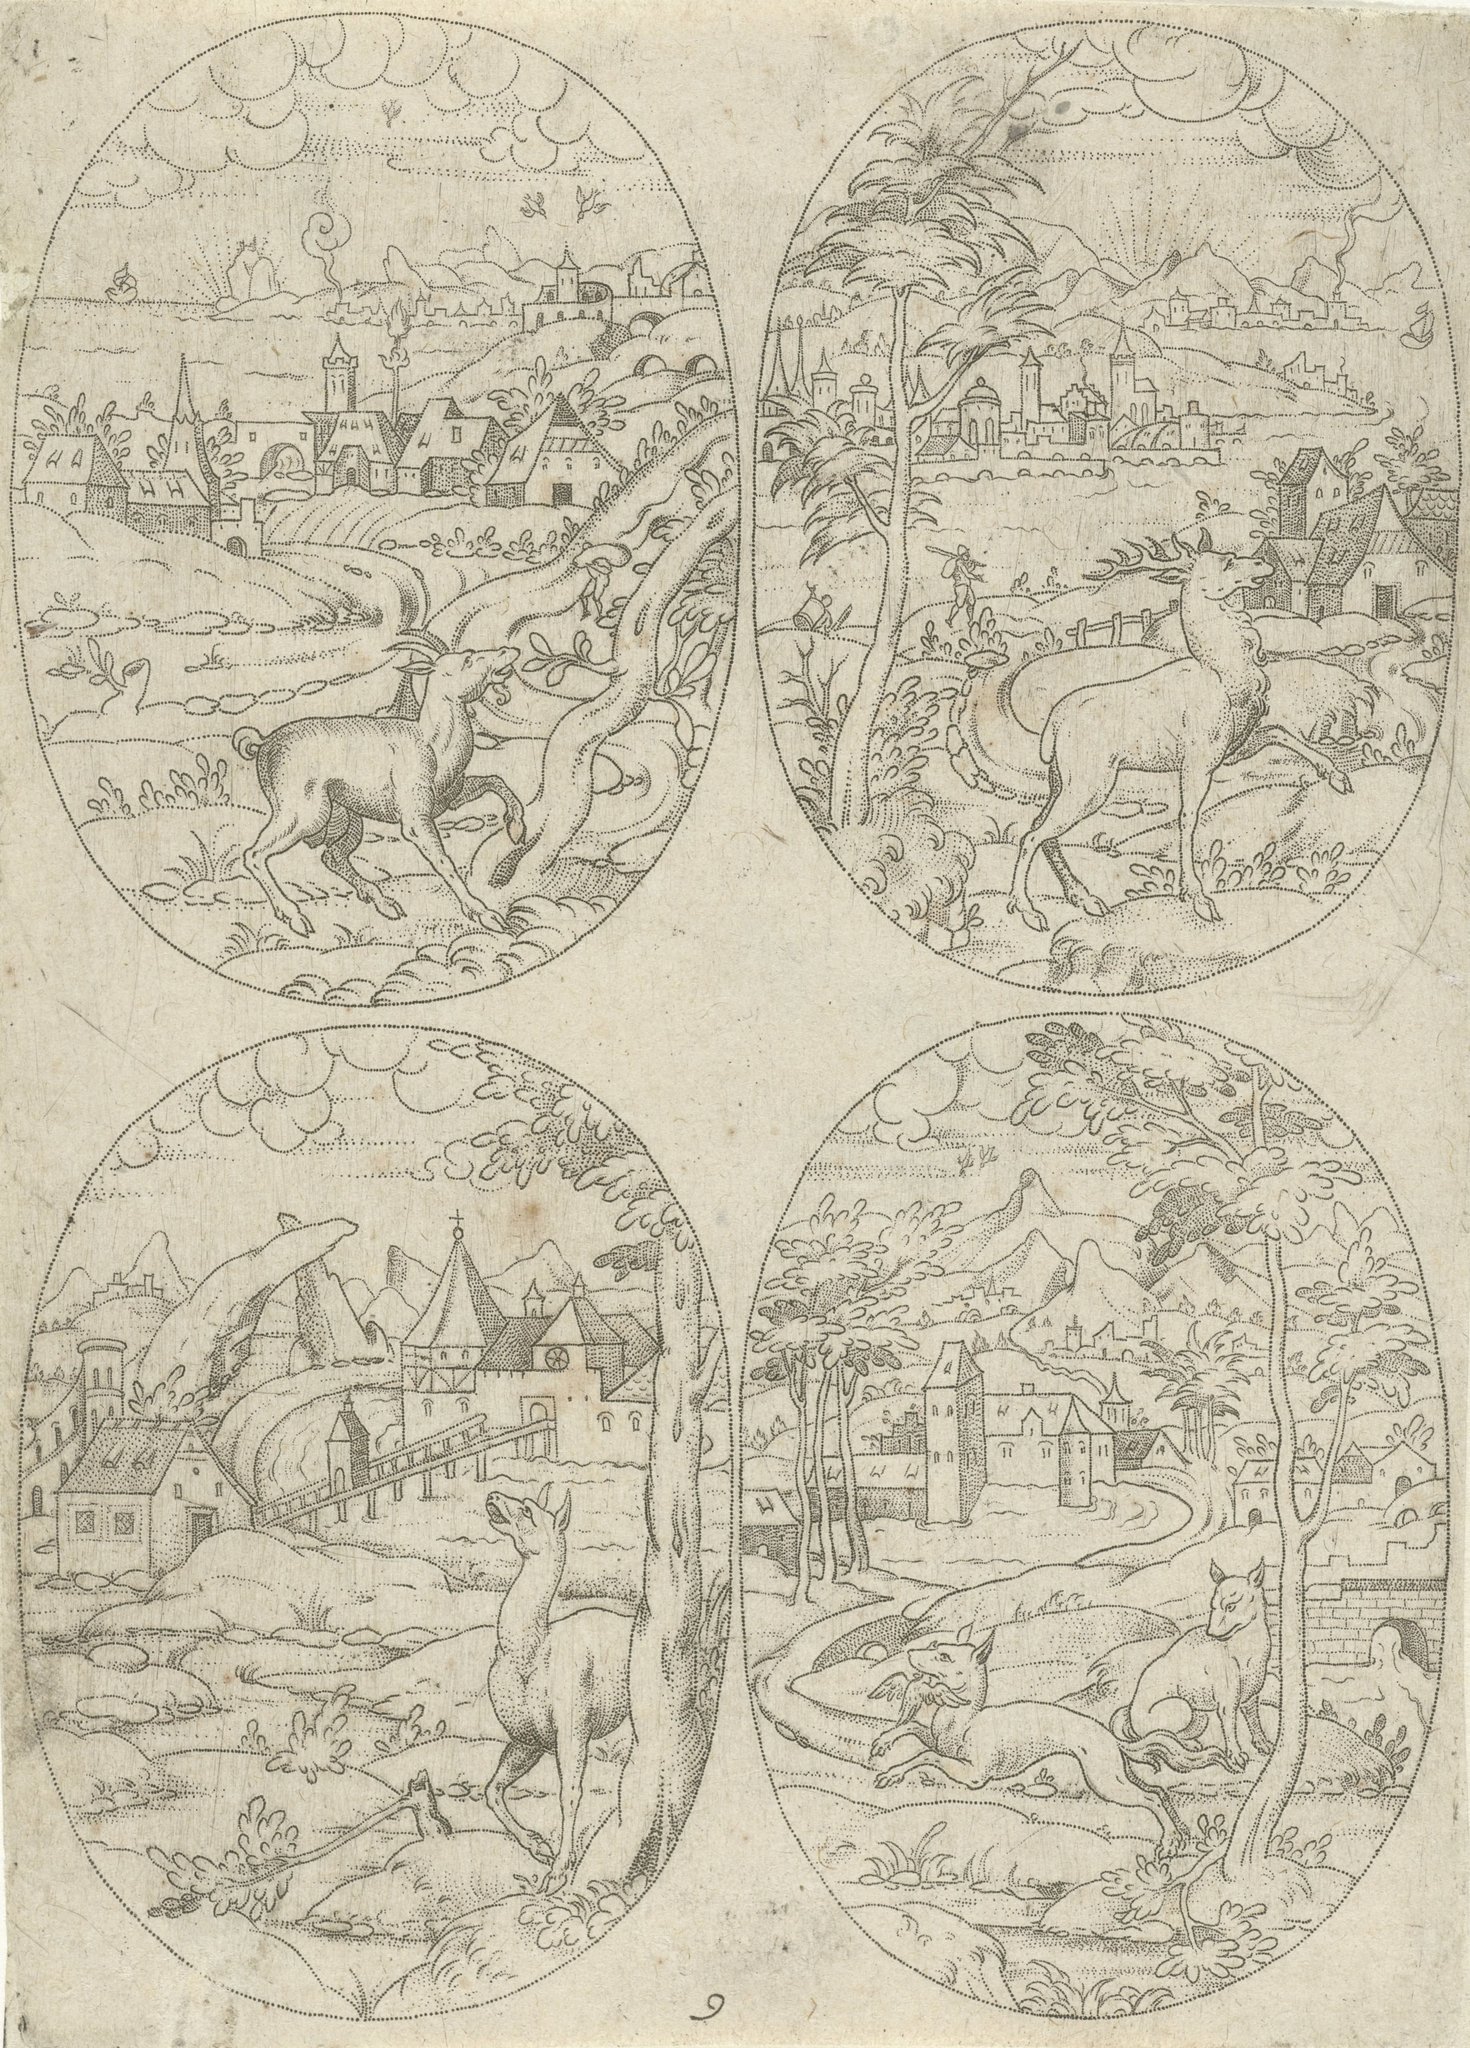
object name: ornament print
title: Vier ovalen met dieren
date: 1500-1635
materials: paper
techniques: engraving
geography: germany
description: Linksboven een bok, rechtsboven een hert, linksonder een paard en rechtsonder twee honden. Blad uit serie van 25 genummerde bladen.